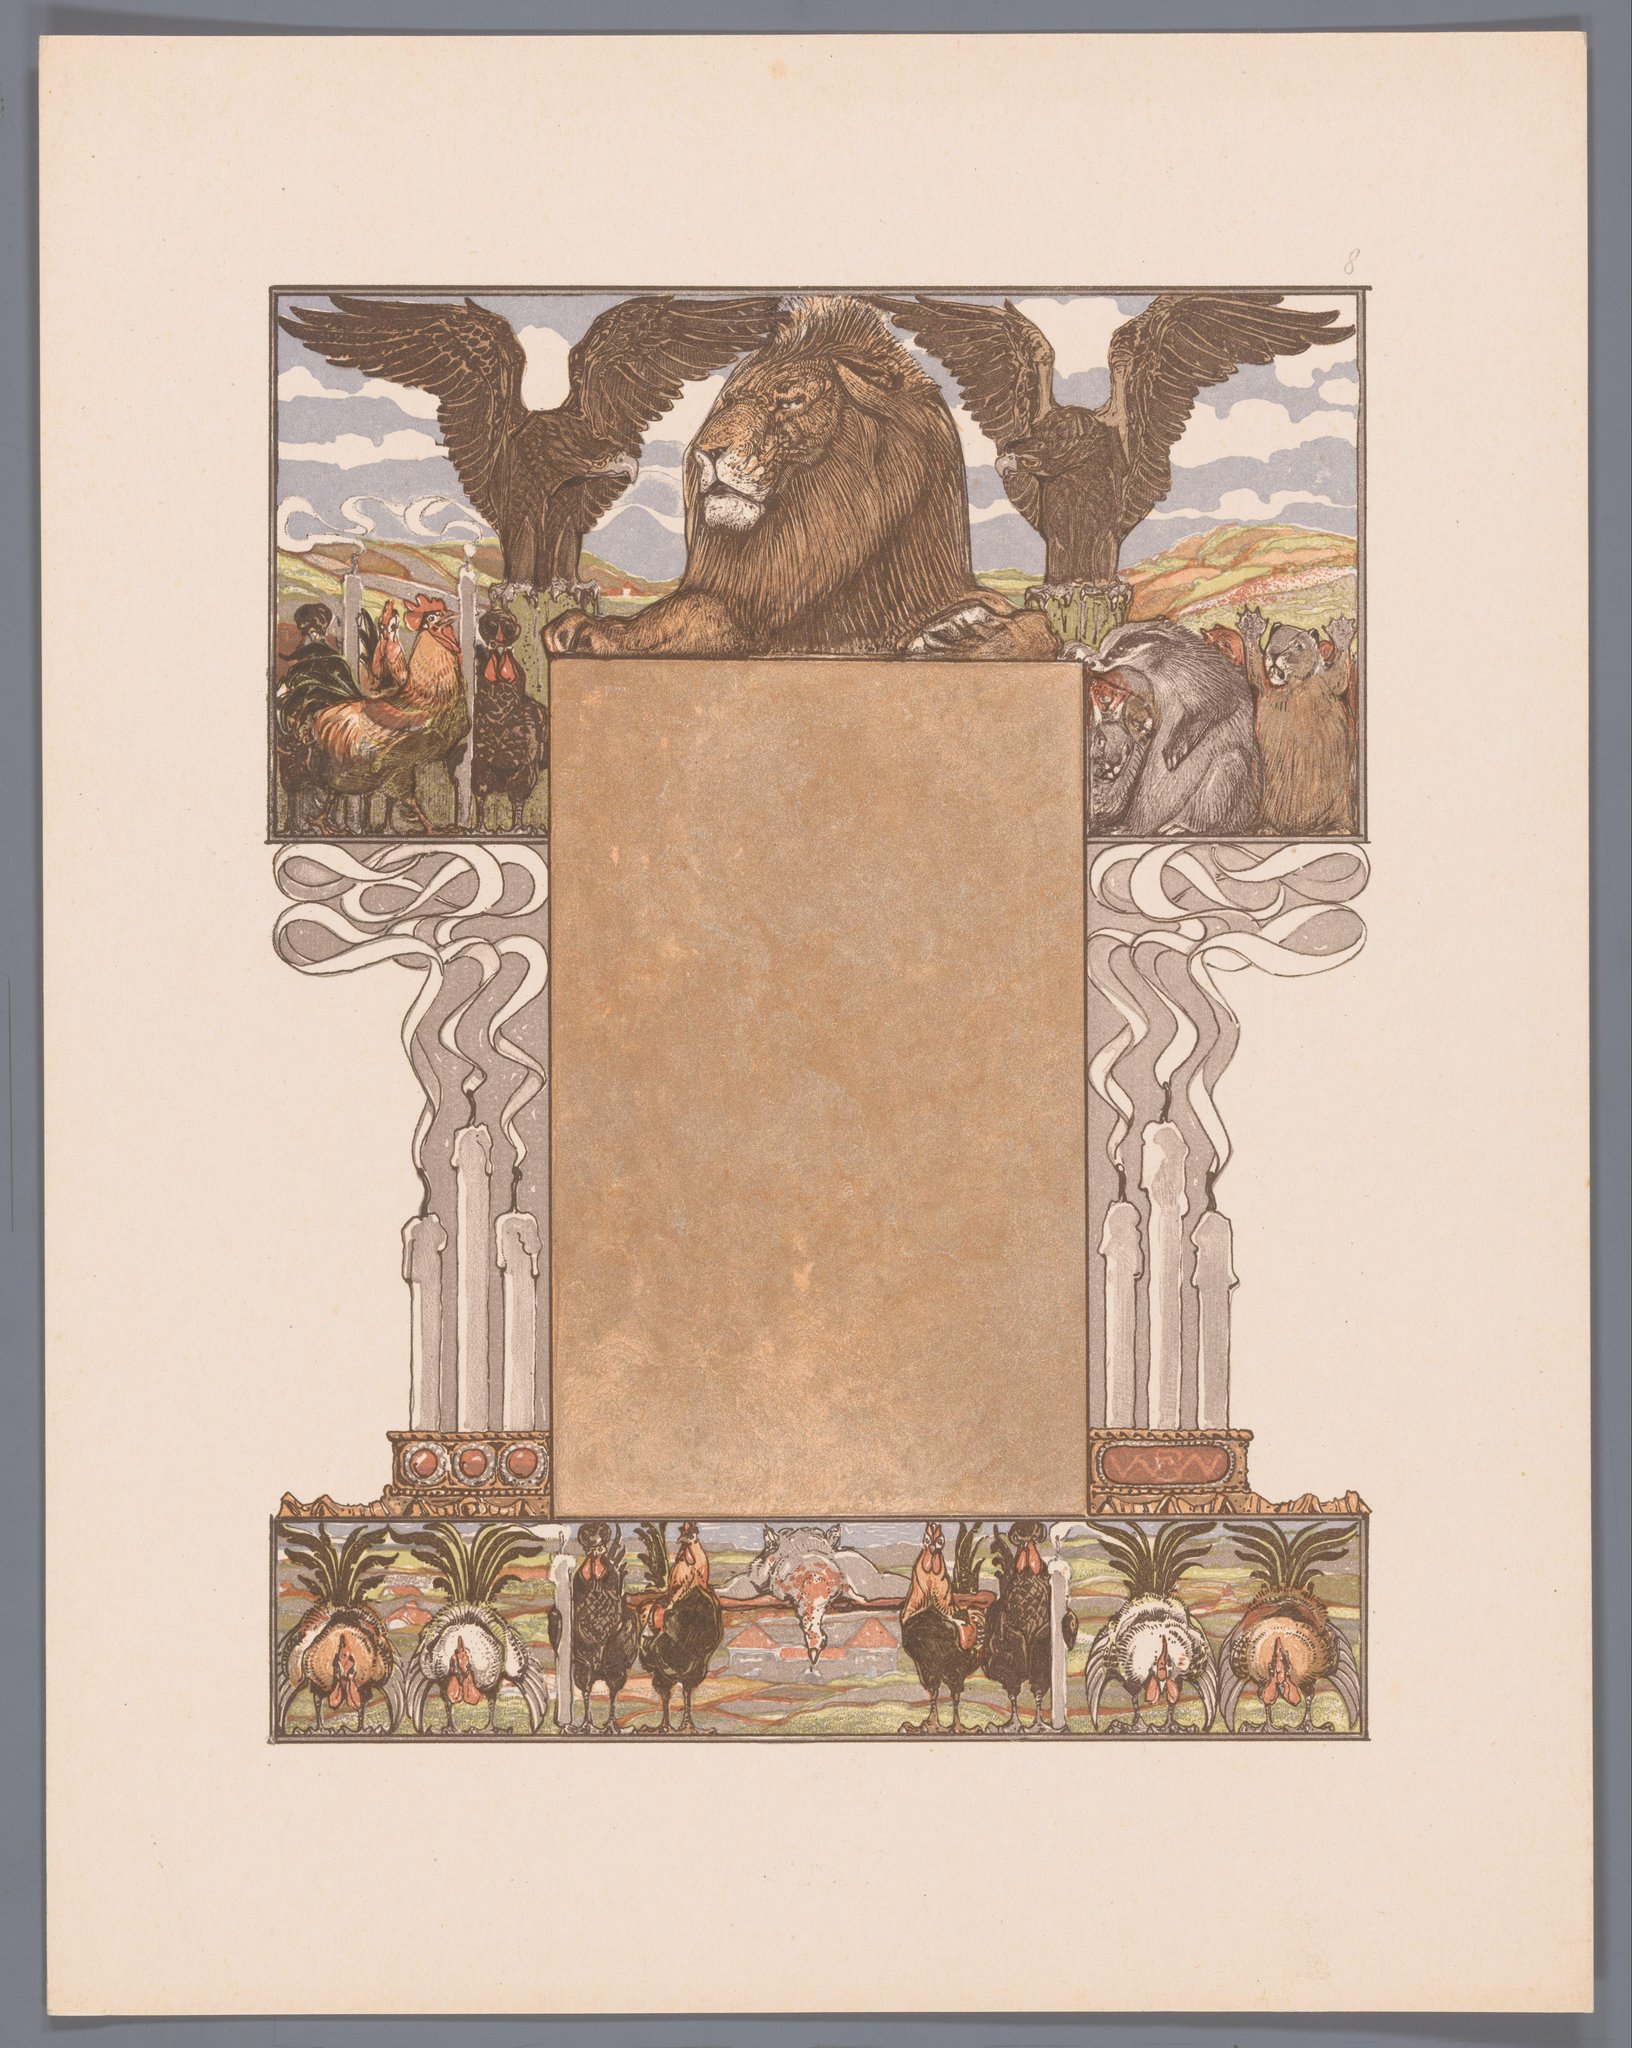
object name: print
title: Gedoofde kaarsen en leeuw (Nobel) geflankeerd door adelaars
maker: bernard willem wierink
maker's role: draughtsman, print maker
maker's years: 1856-1939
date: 1910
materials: paper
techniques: lithograph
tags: fable of reynard the fox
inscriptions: collector's mark: Lugt 2228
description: Ontwerp voor: Streuvels, Stijn (Frank Lateur). Reinaert de Vos naar verschillende uitgaven van het middeleeuwsche epos. Amsterdam: L.J. Veen, 1910.